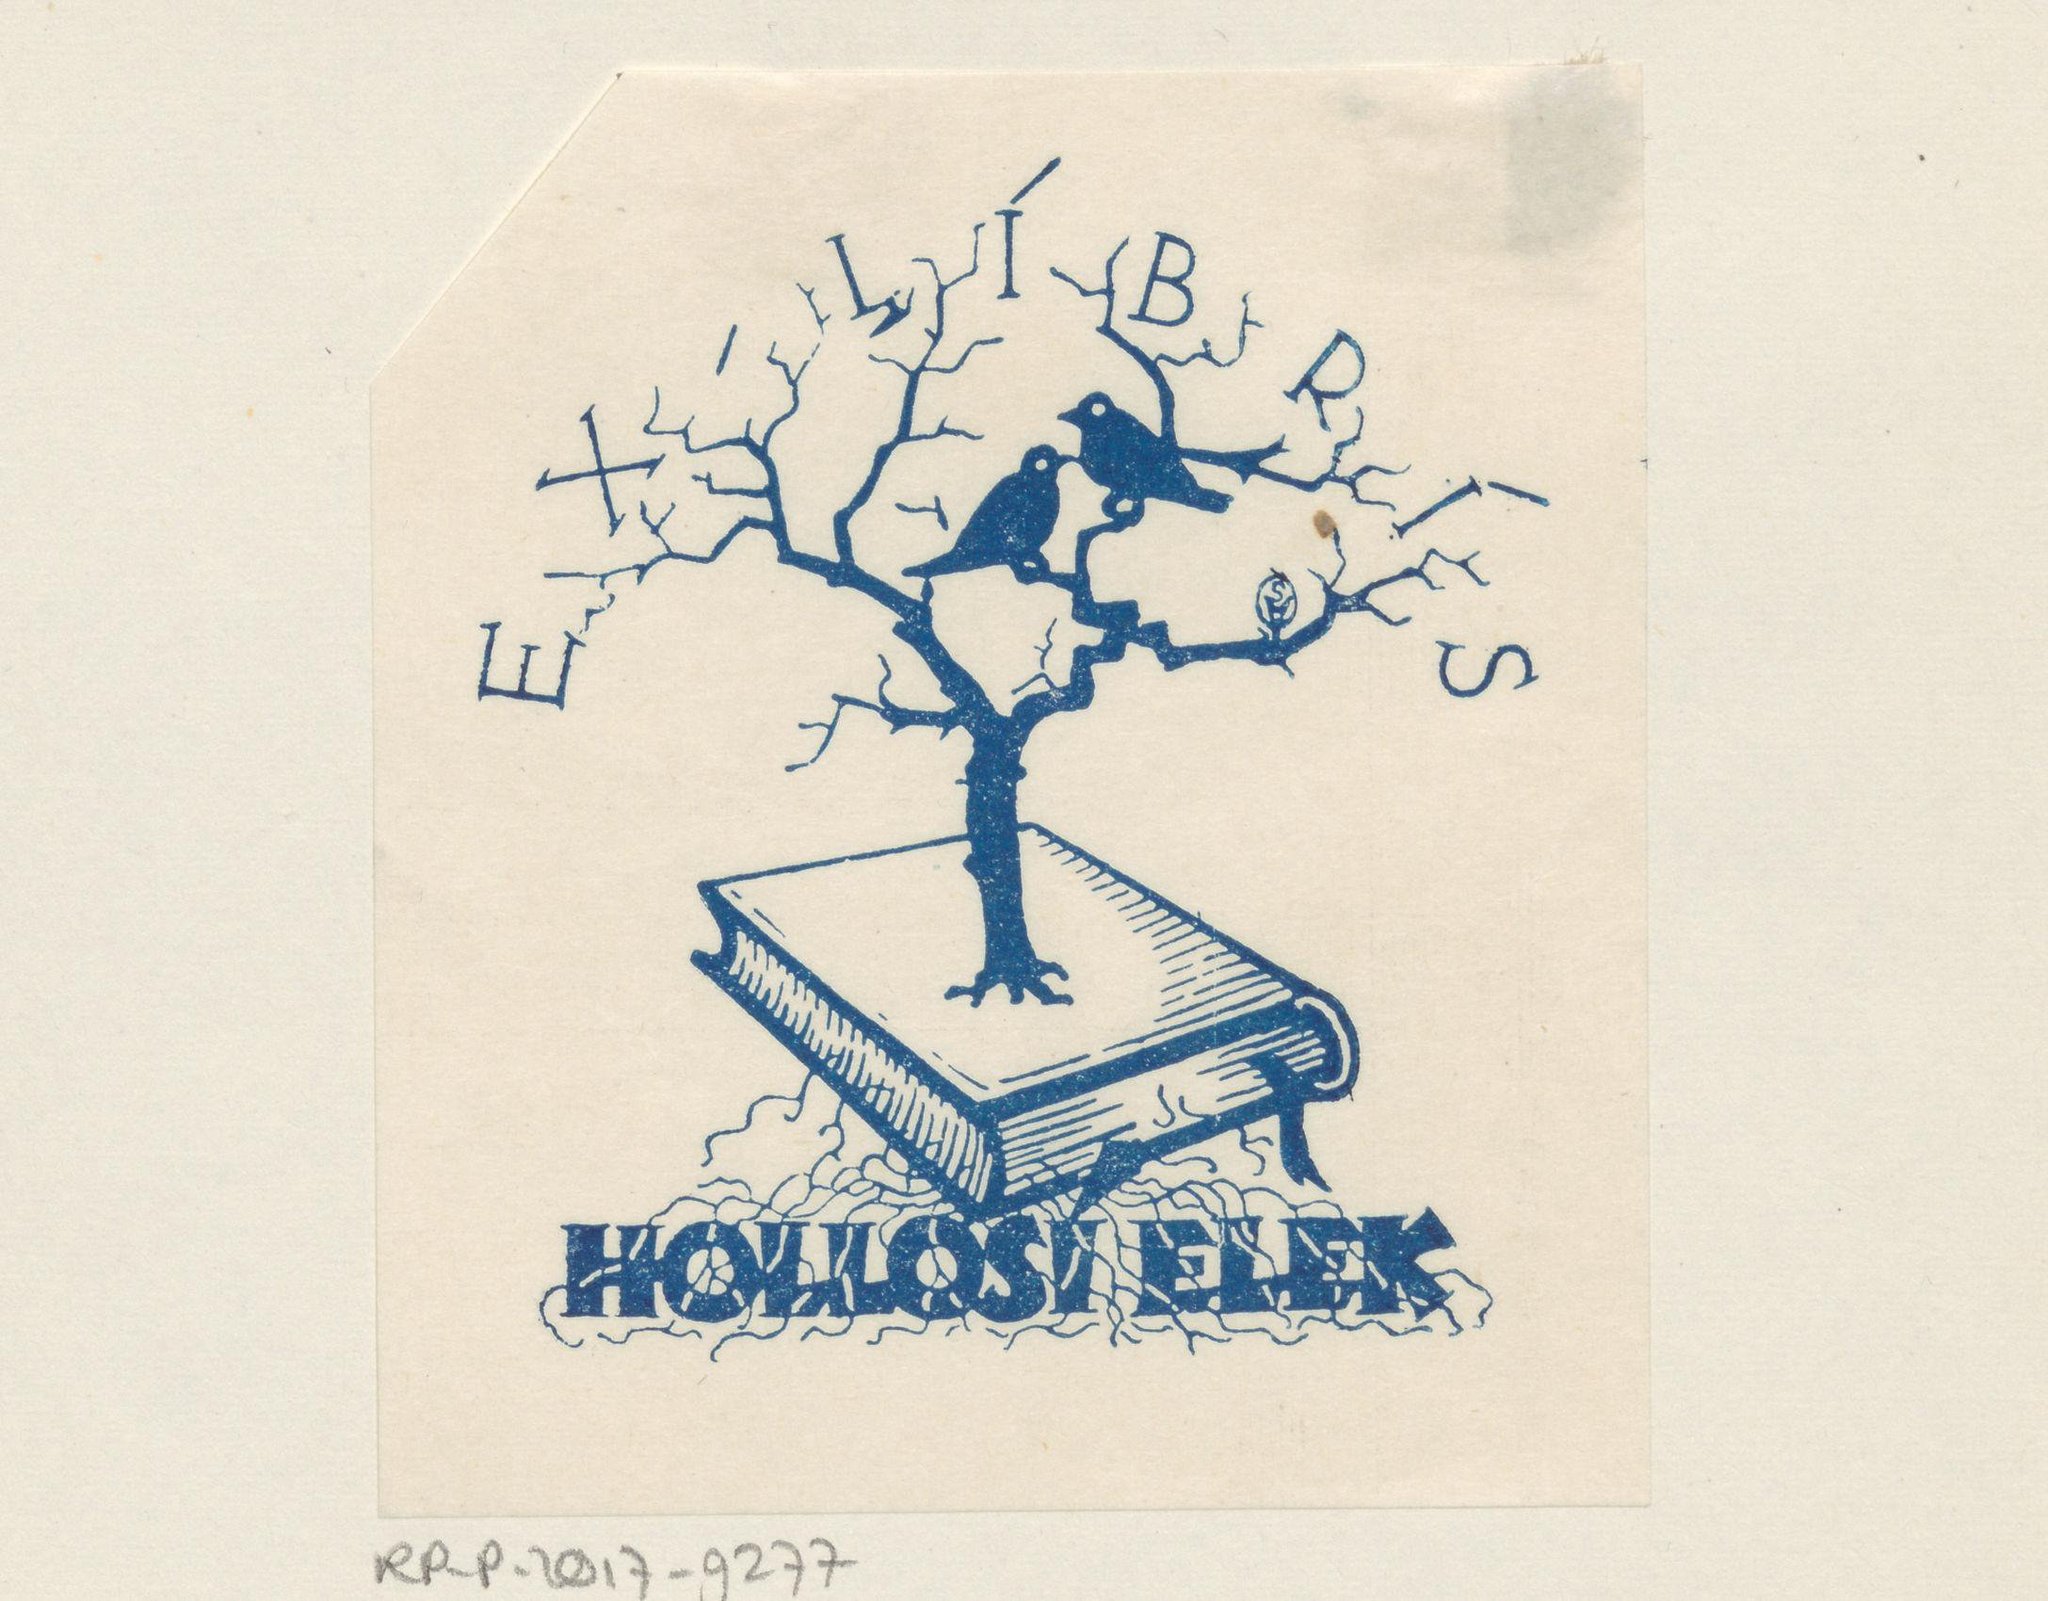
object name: bookplate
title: Ex libris van Hollosí Elek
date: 1900-1999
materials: paper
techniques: printing block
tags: trees, birds, book